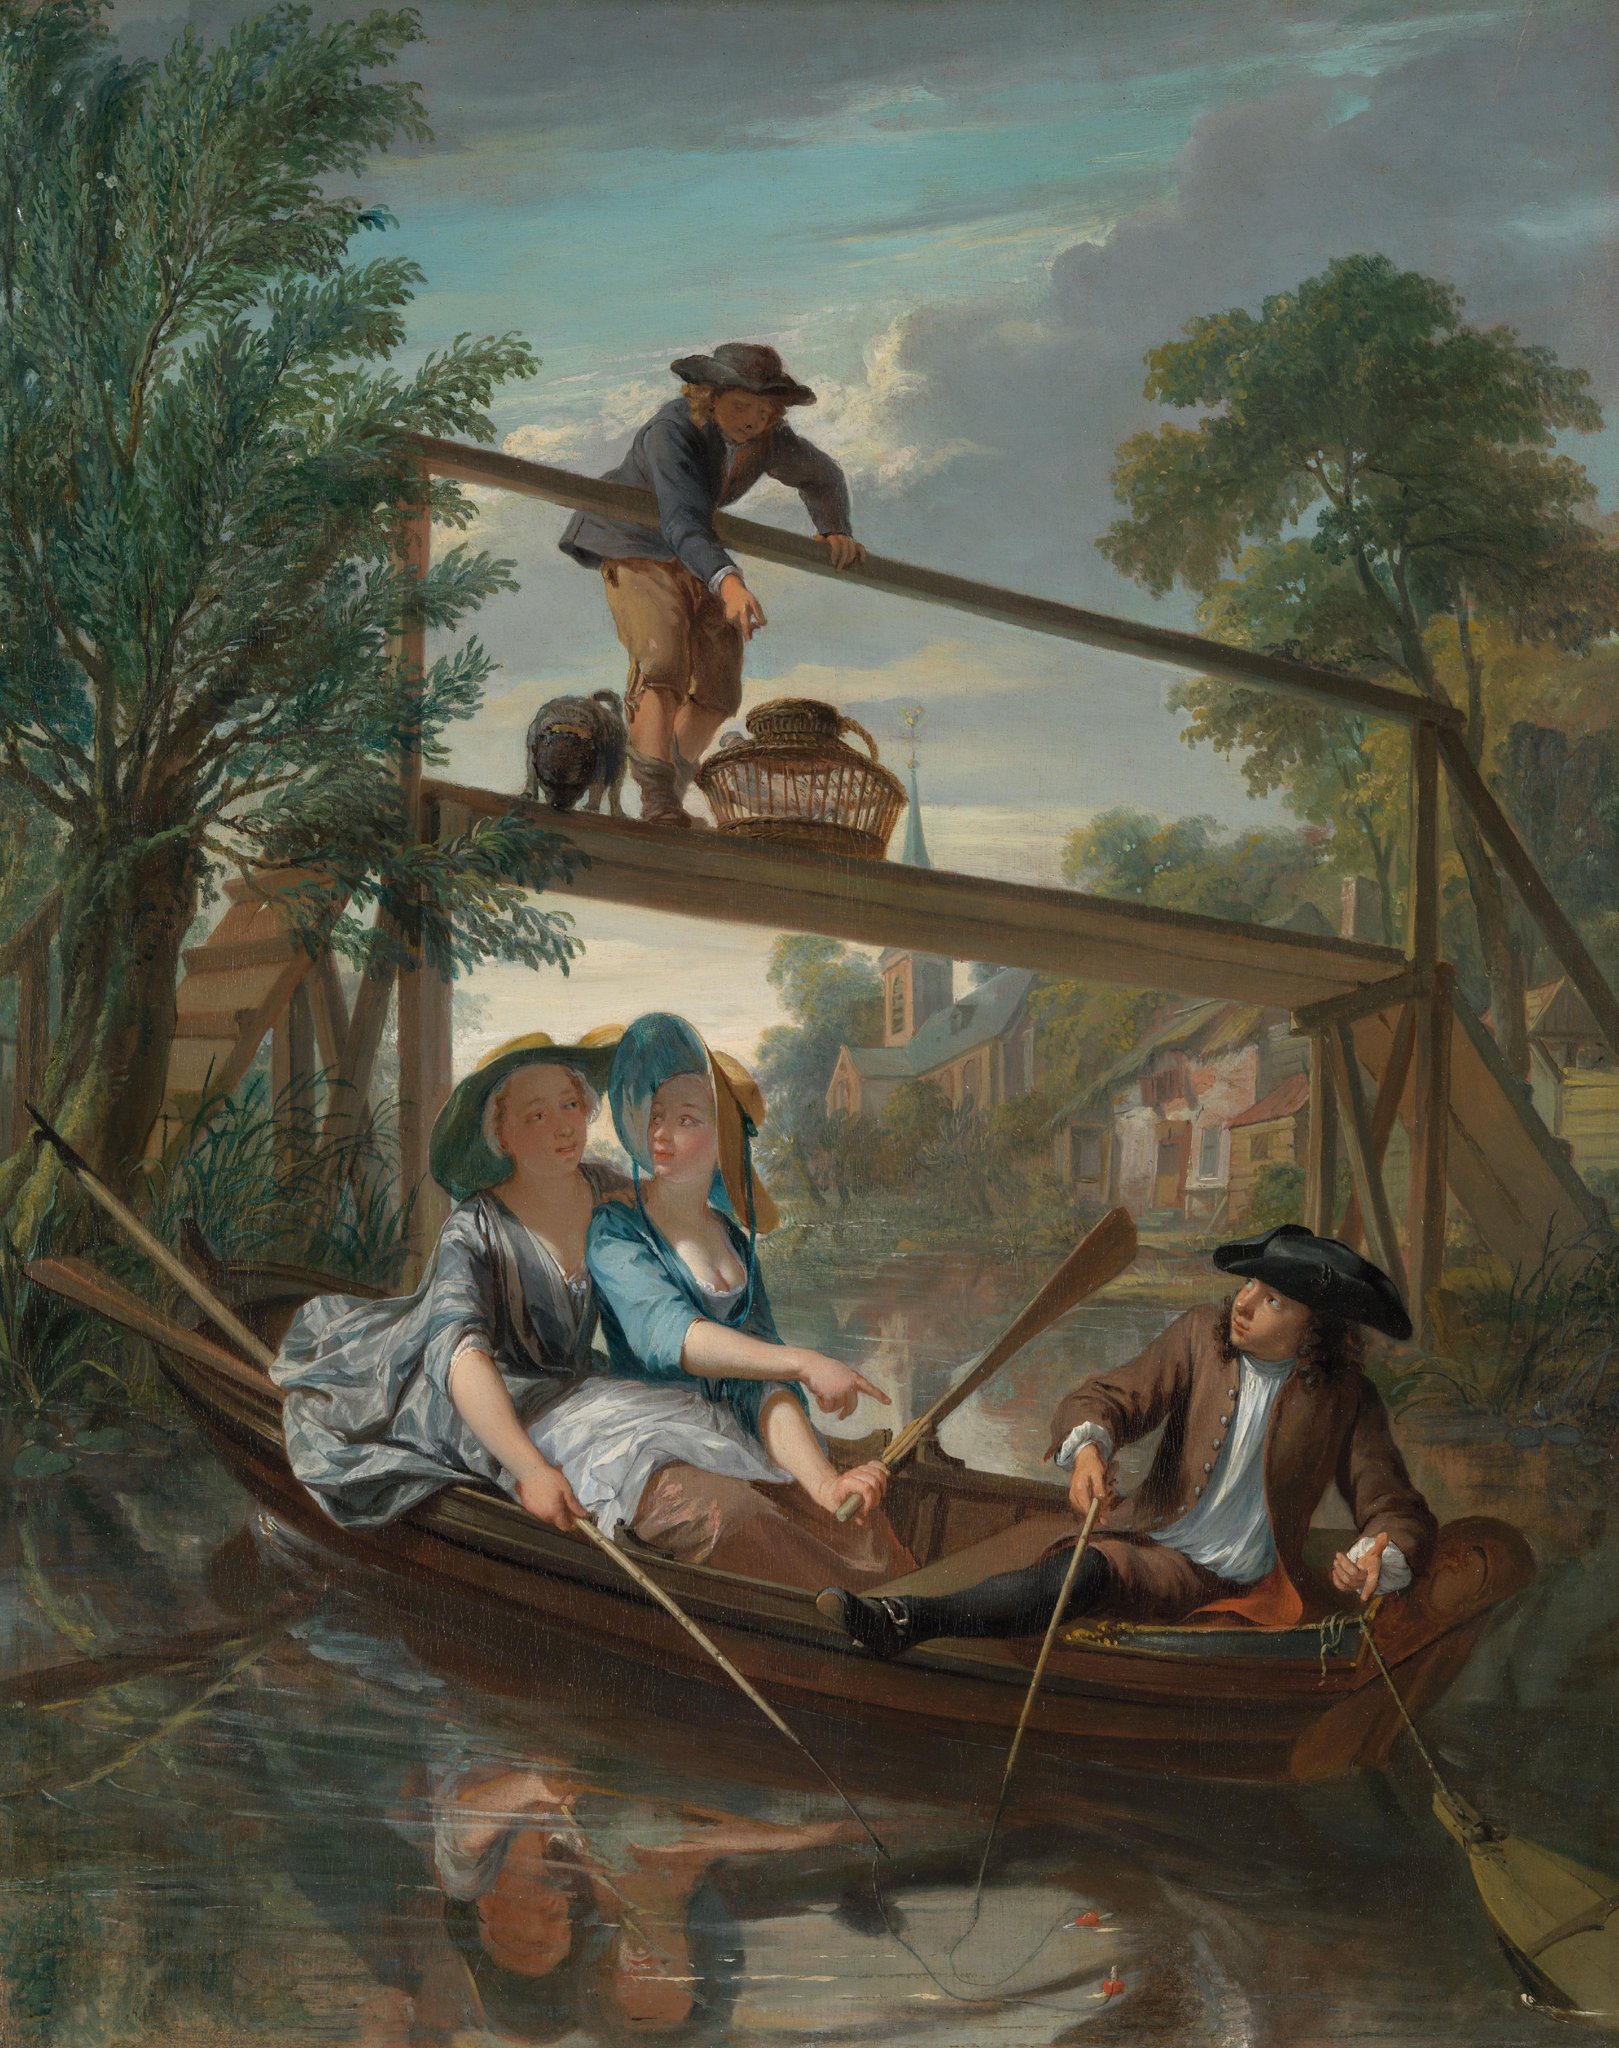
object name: painting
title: The Anglers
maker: nicolaas verkolje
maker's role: draughtsman, painter, print maker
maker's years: 1673-1746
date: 1744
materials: oil, paint, panel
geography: amsterdam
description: Gotcha! Both the men and the women gesture in the direction of the float lying on its side. But who is being hooked here? The ambiguous meaning of this innocentlooking scene will not have escaped the 18th-century viewer. In those days, fishing and catching birds, the subject of the accompanying painting (also on view on this wall), were well-known metaphors for making love.